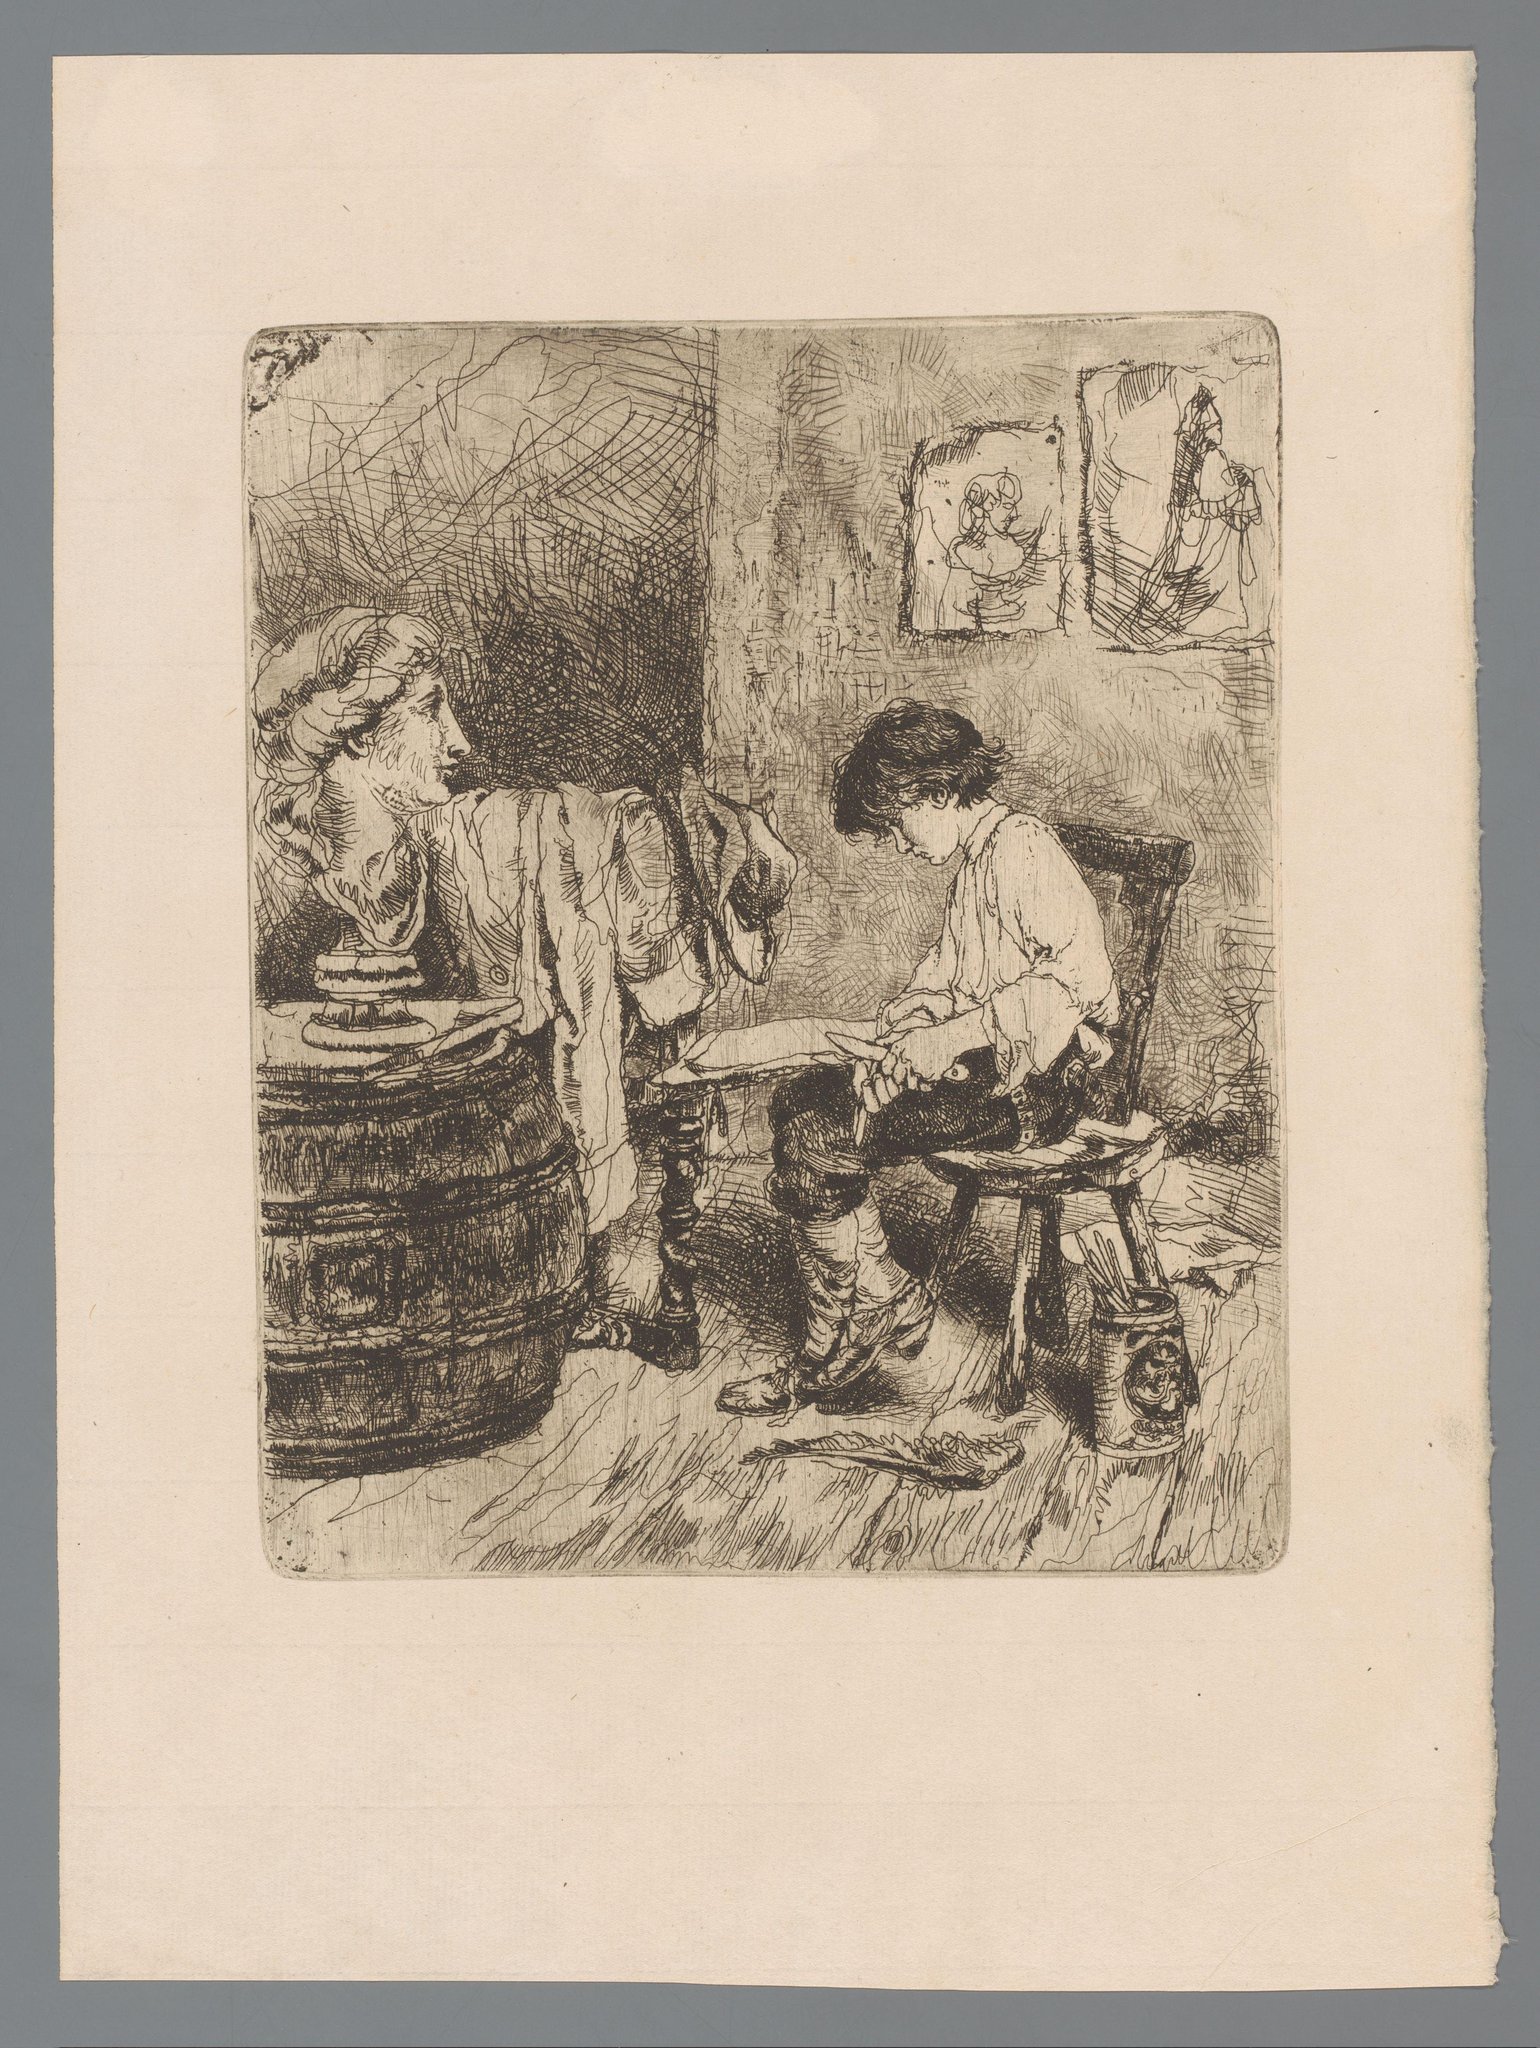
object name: print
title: In een atelier zit een jongen tegenover een borstbeeld te tekenen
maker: willem linnig (ii)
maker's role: print maker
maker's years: 1842-1890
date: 1852-1890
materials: paper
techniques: drypoint, etching, intaglio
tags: drawing, artist at work, in his workshop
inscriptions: collector's mark: Lugt 2228